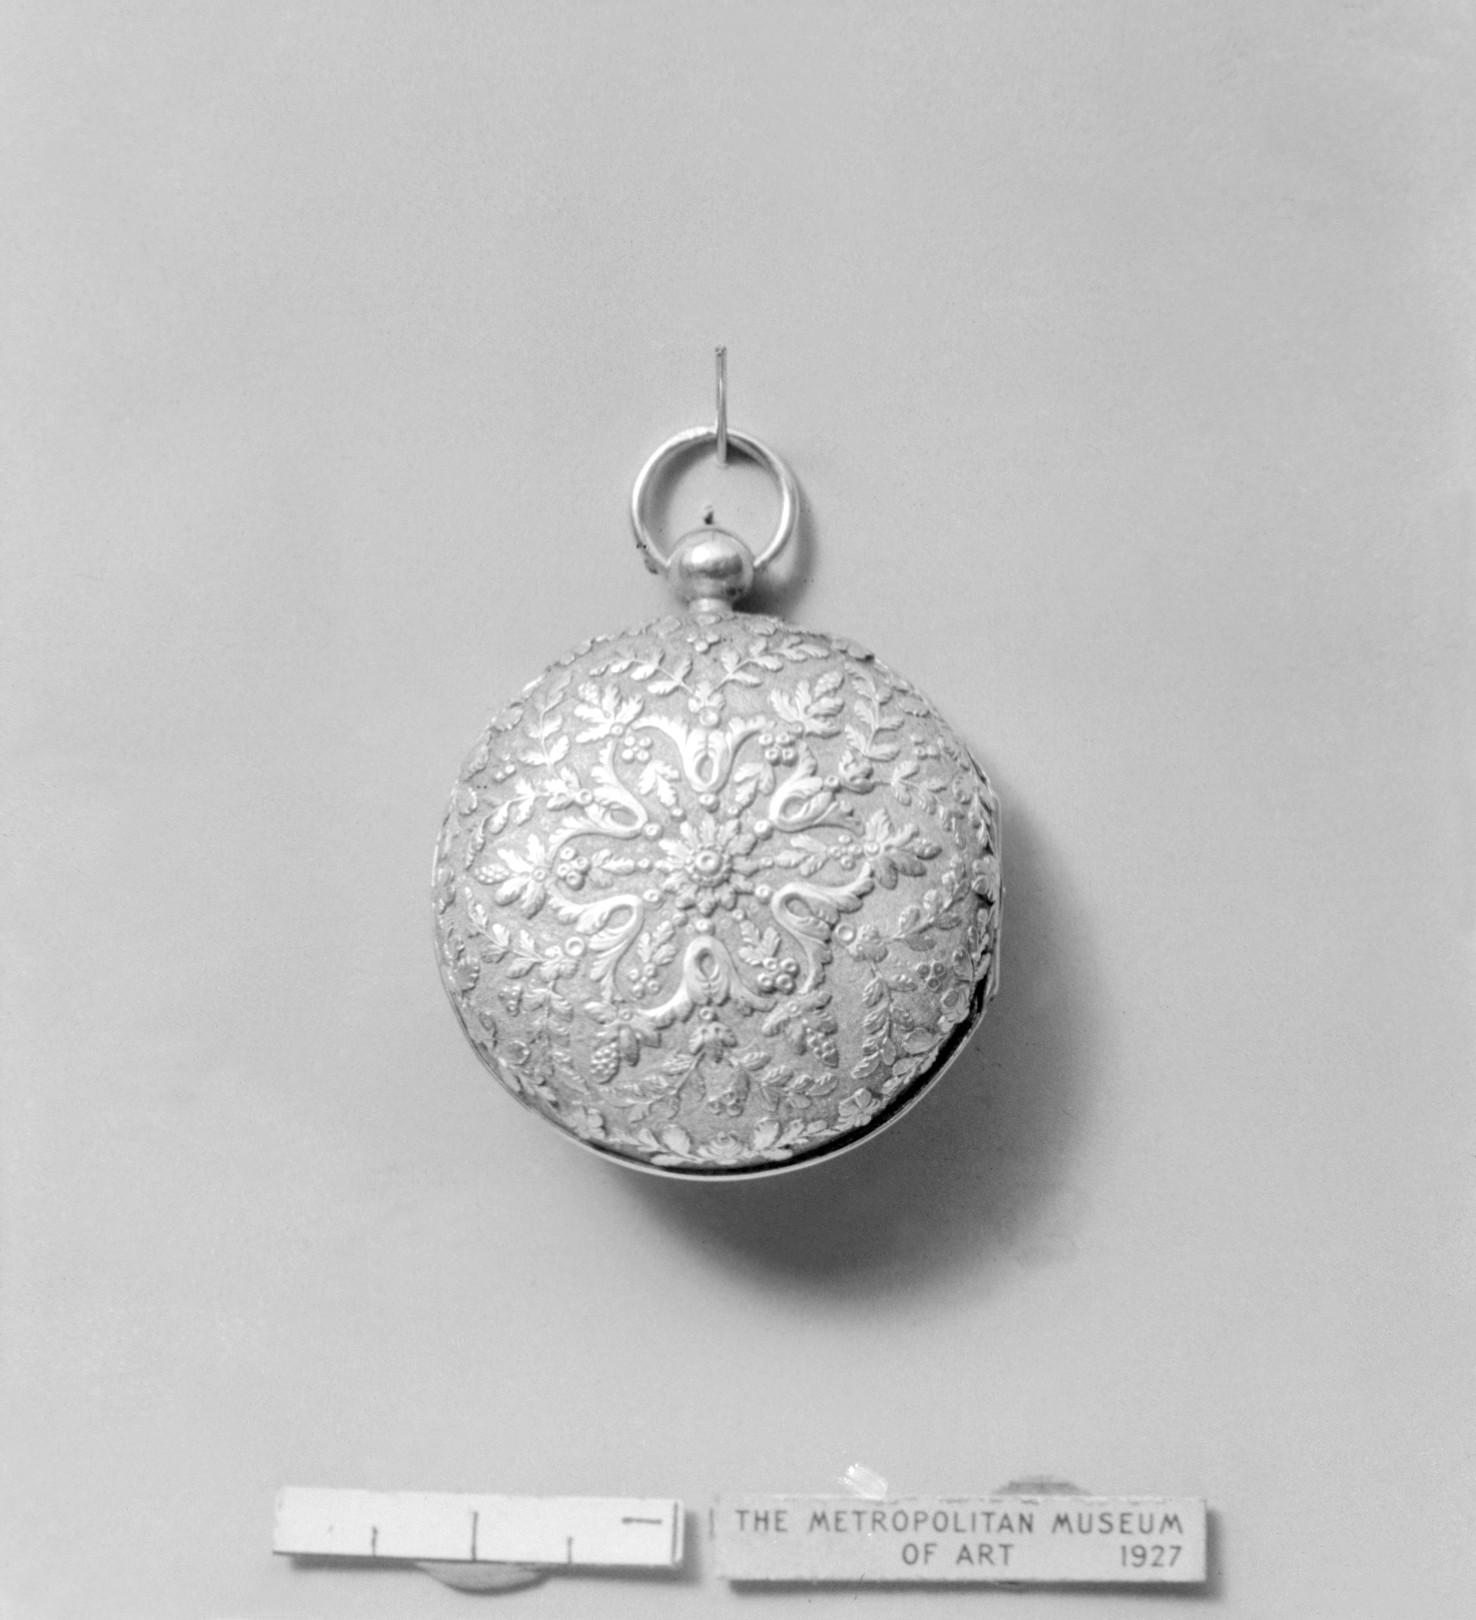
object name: watch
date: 1819-1838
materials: gold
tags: flowers,leaves